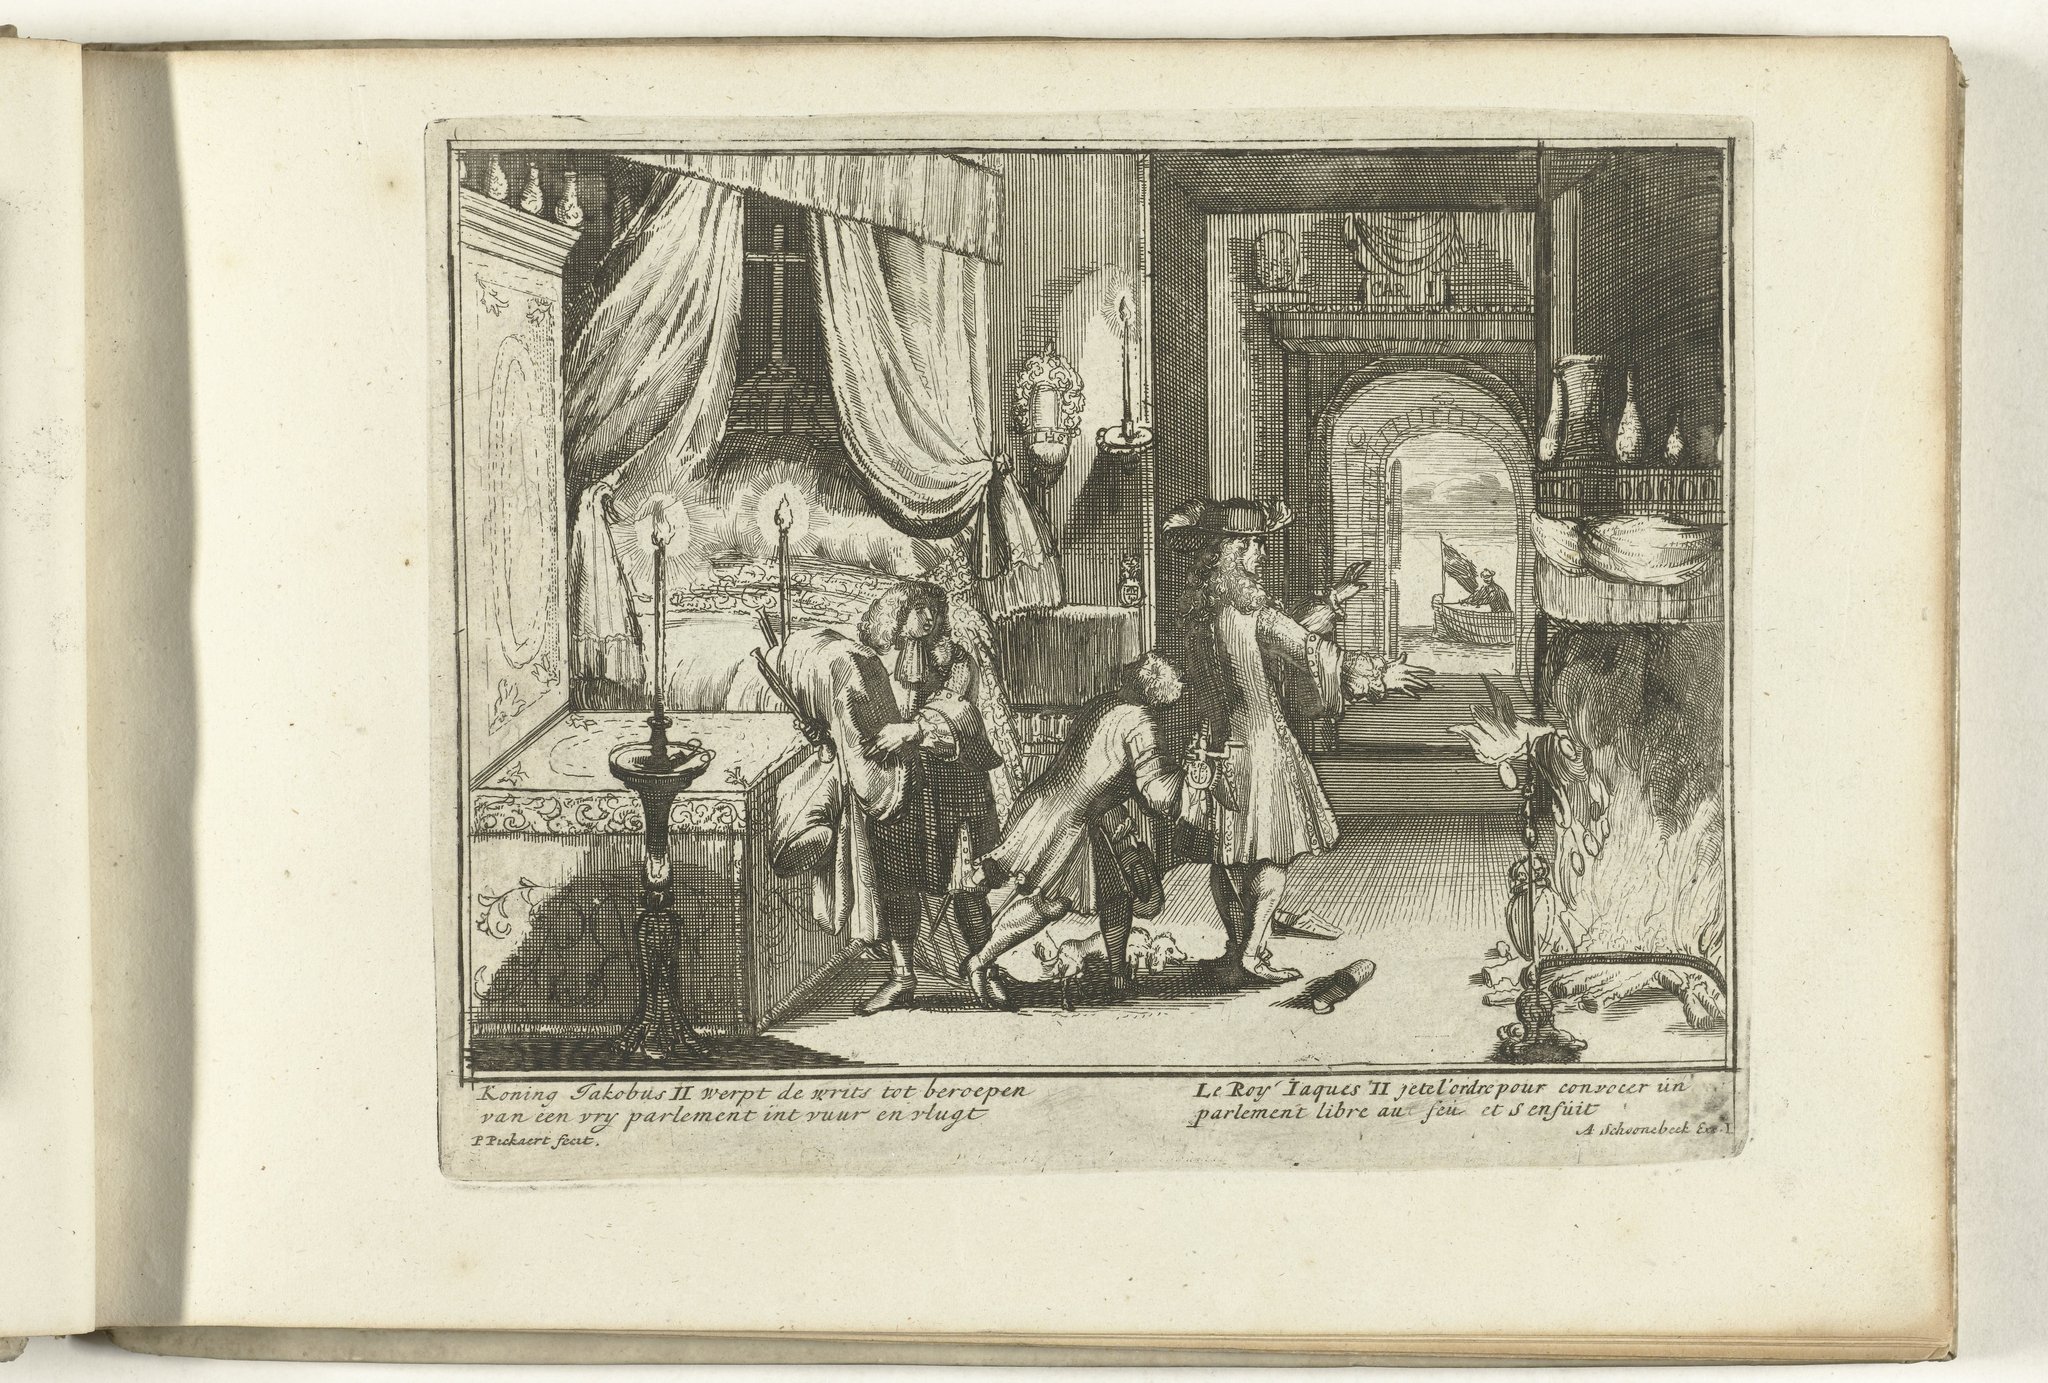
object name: print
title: Engelants schouwtoneel, verbeeldende het vlugte van Jacobus II, Koning van Groot Brittanyen etc. met desselfs aankomst in Yrlant en verdere voorvallen, I Deel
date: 1689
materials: paper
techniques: etching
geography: amsterdam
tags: jacobus ii (koning van engeland en schotland), flight of ruler from adversary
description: De Engelse koning Jacobus II werpt de voorstellen voor een vrij parlement in het vuur en vlucht, 20 december 1688. Plaat J in de serie 'Engelants schouwtoneel' over de Glorious Revolution en gebeurtenissen uit de voorafgaande jaren 1685-1689 (eerste deel). Met onderschriften in het Nederlands en Frans.